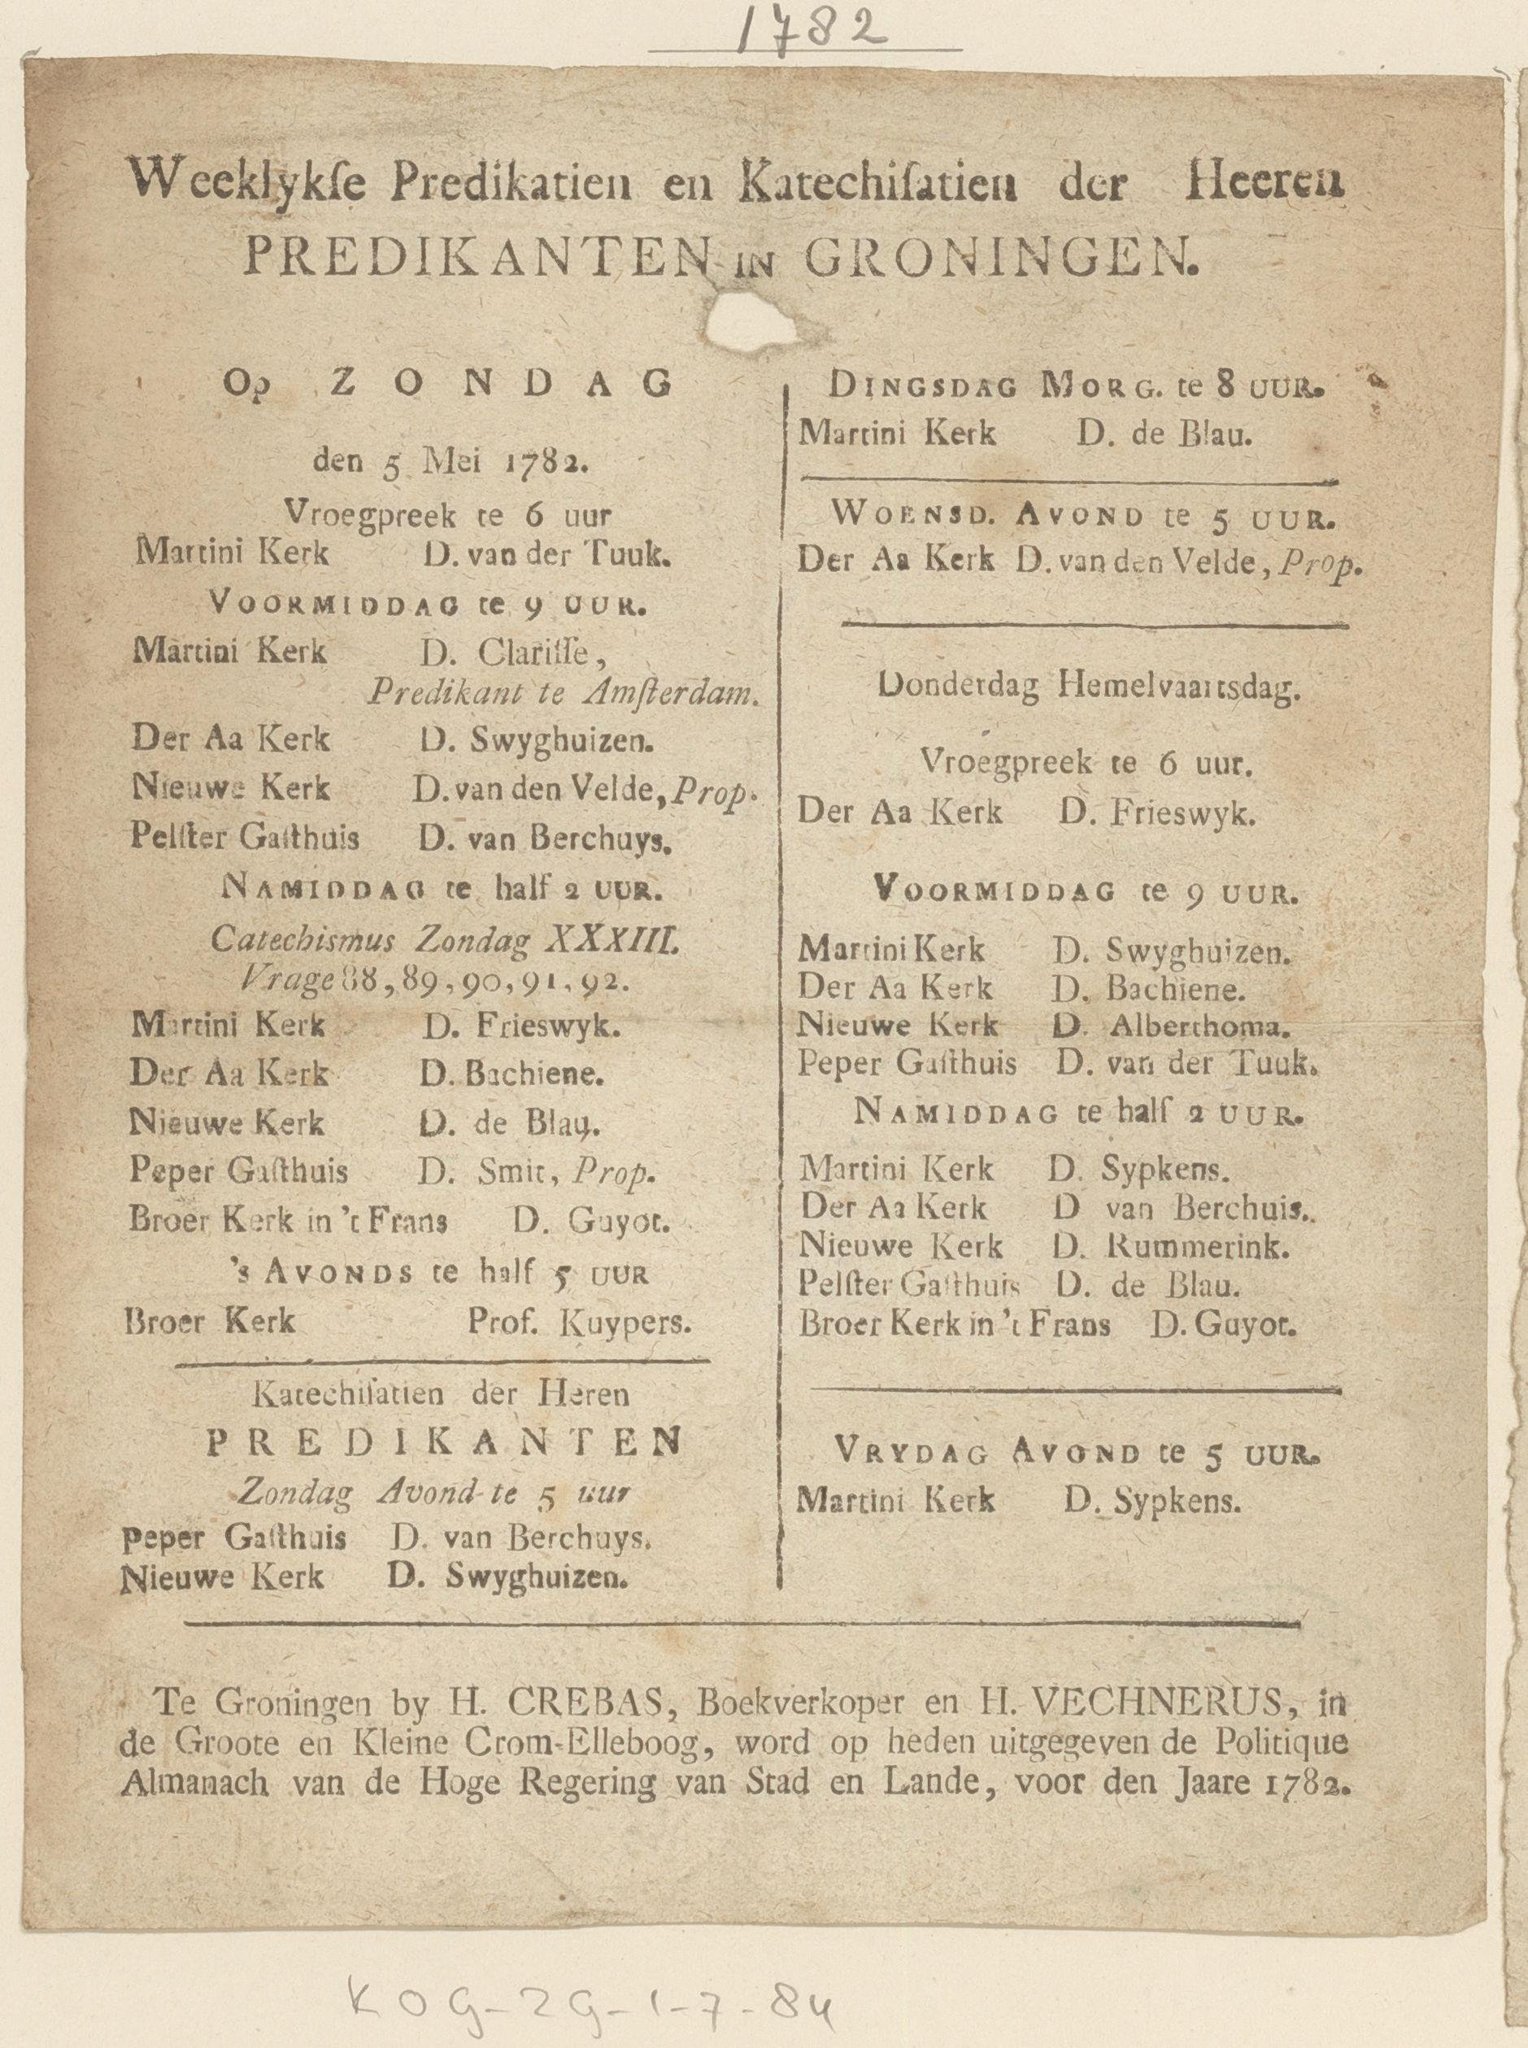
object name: text sheet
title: Weeklykse Predikatien en Katechisatien der Heeren Predikanten in Groningen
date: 1782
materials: paper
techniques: letterpress printing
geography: groningen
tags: preaching (in general)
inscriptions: stamp, collector's mark: Lugt 1641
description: Preken in Groningen in de week van 5 mei 1782, met de namen van de predikanten. Onderwerpsrubrieken binnen de Atlas Zeden en Gewoonten: Godsdienst, Predikbeurtenlijstjes.